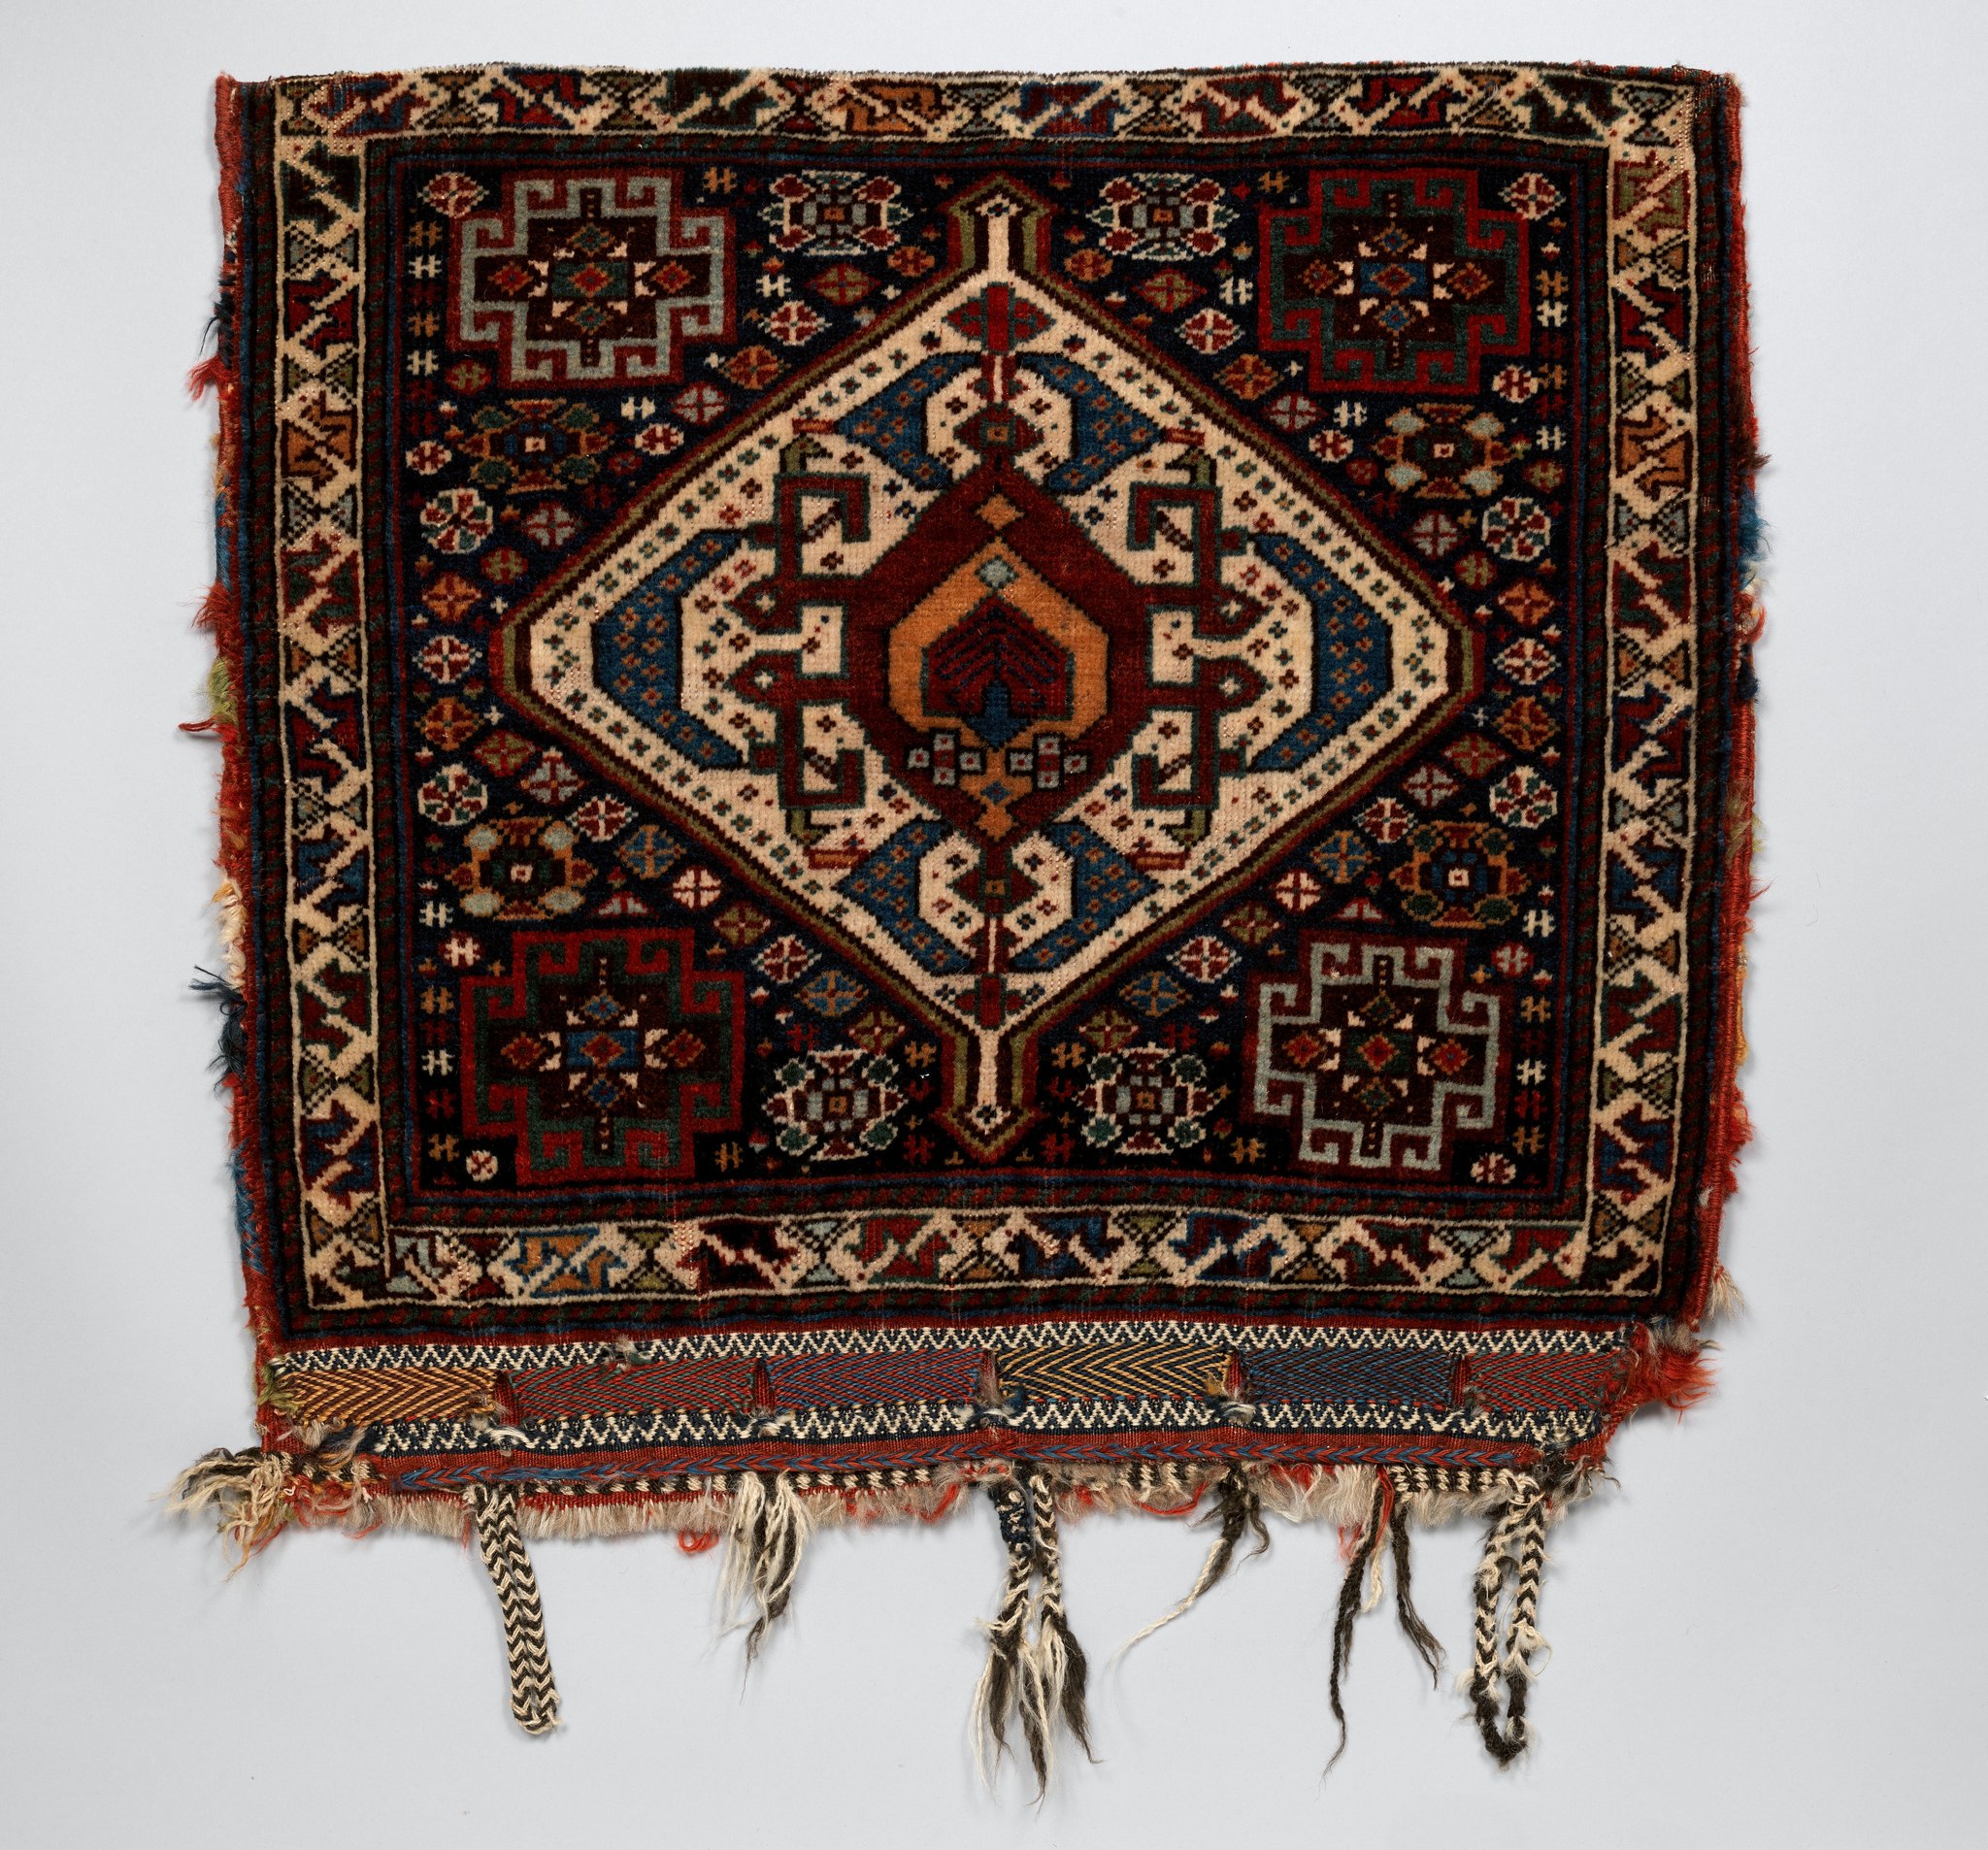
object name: saddle bag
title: Half of Double Saddle Bag (Khorjin)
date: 1876-1900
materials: cotton, wool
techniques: asymmetrically knotted pile, brocade, weave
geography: iran